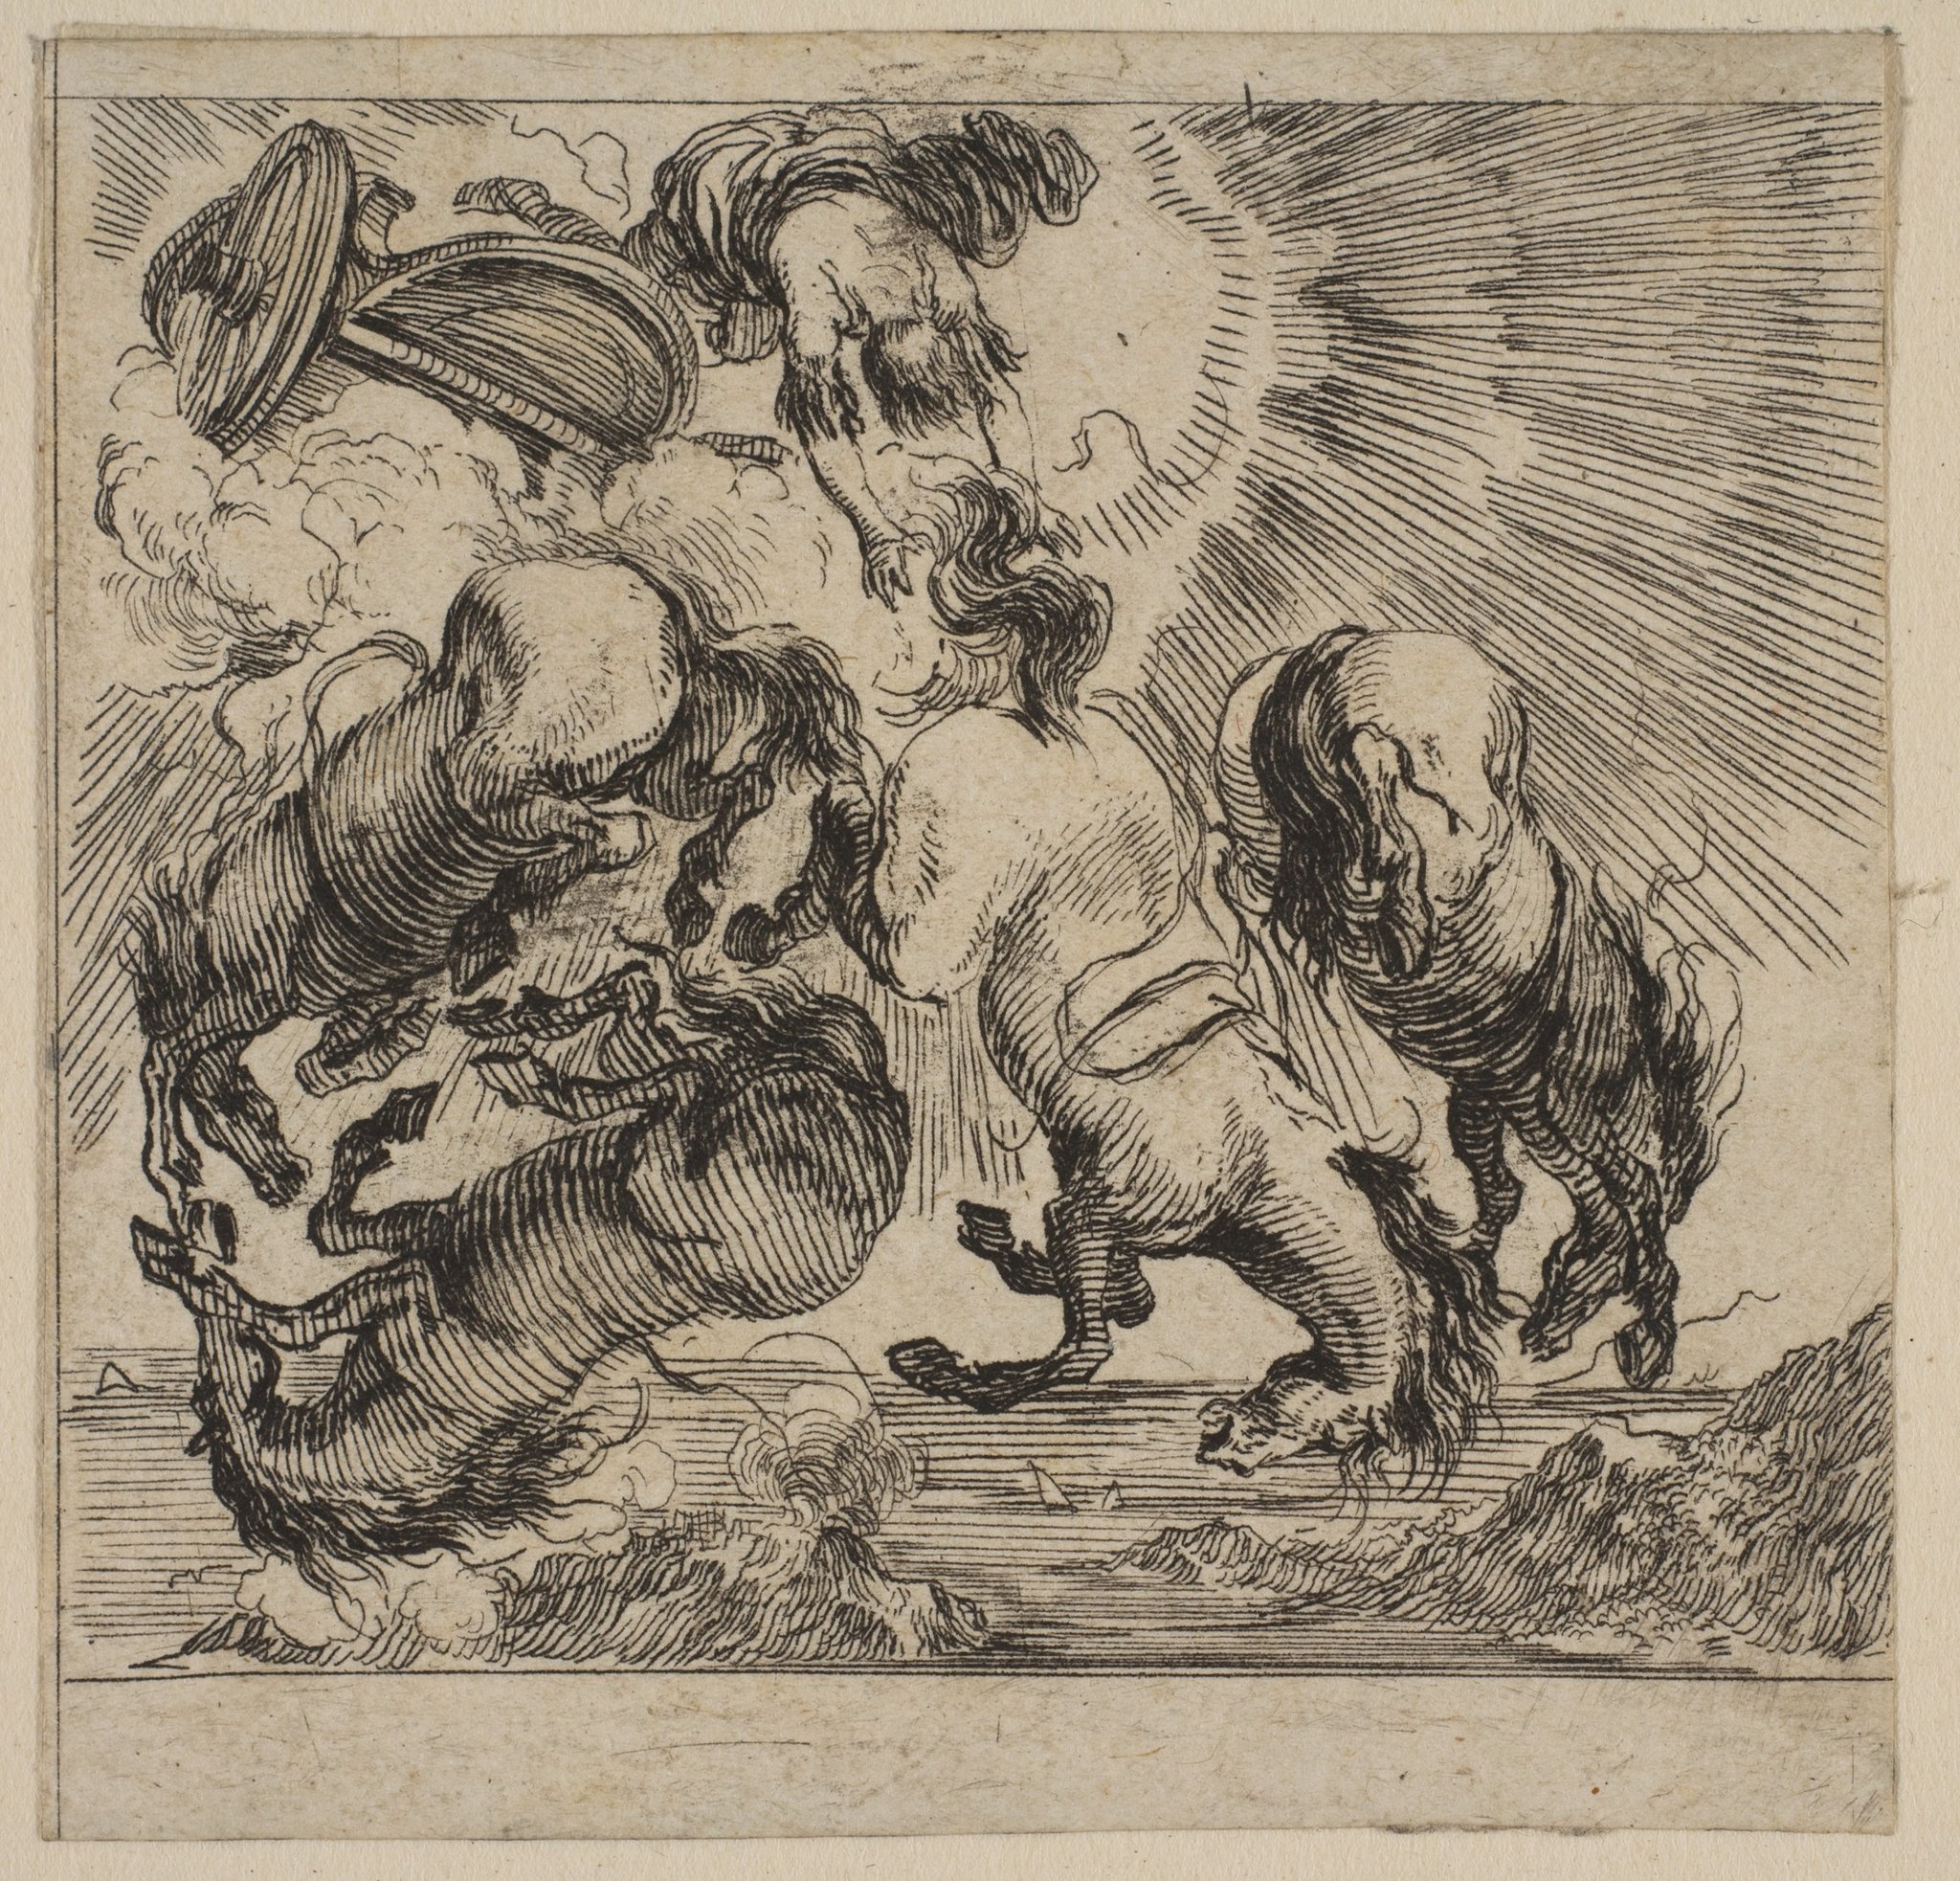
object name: print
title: Phaeton, from 'Game of Mythology' (Jeu de la Mythologie)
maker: stefano della bella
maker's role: artist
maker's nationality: italian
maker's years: 1610-1664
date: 1644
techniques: etching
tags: horses,chariots